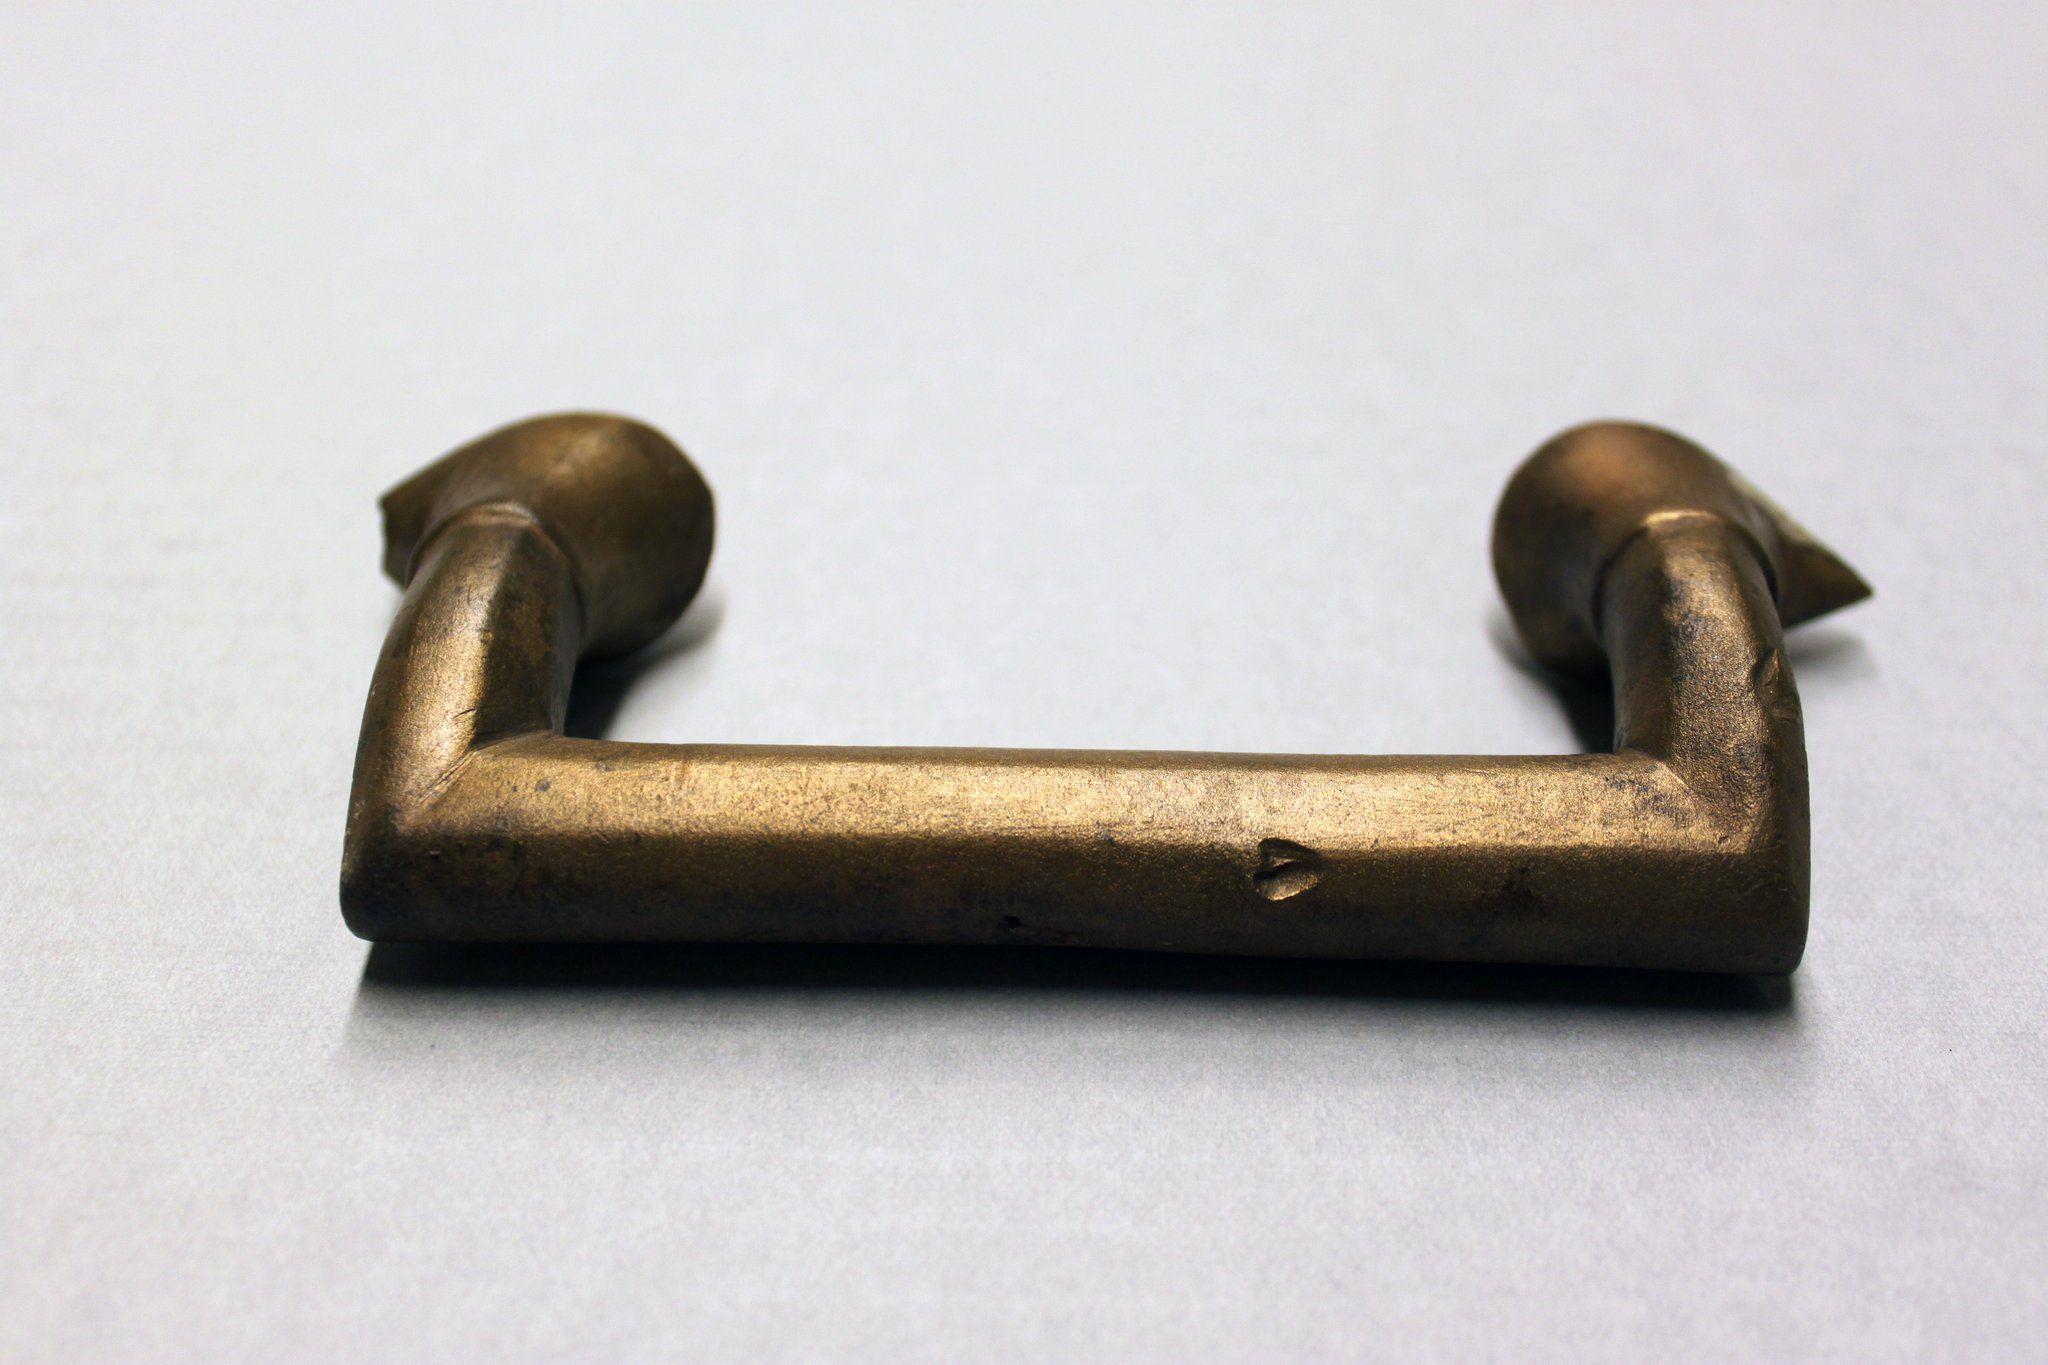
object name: handle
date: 801-1100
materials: bronze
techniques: casting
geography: iran